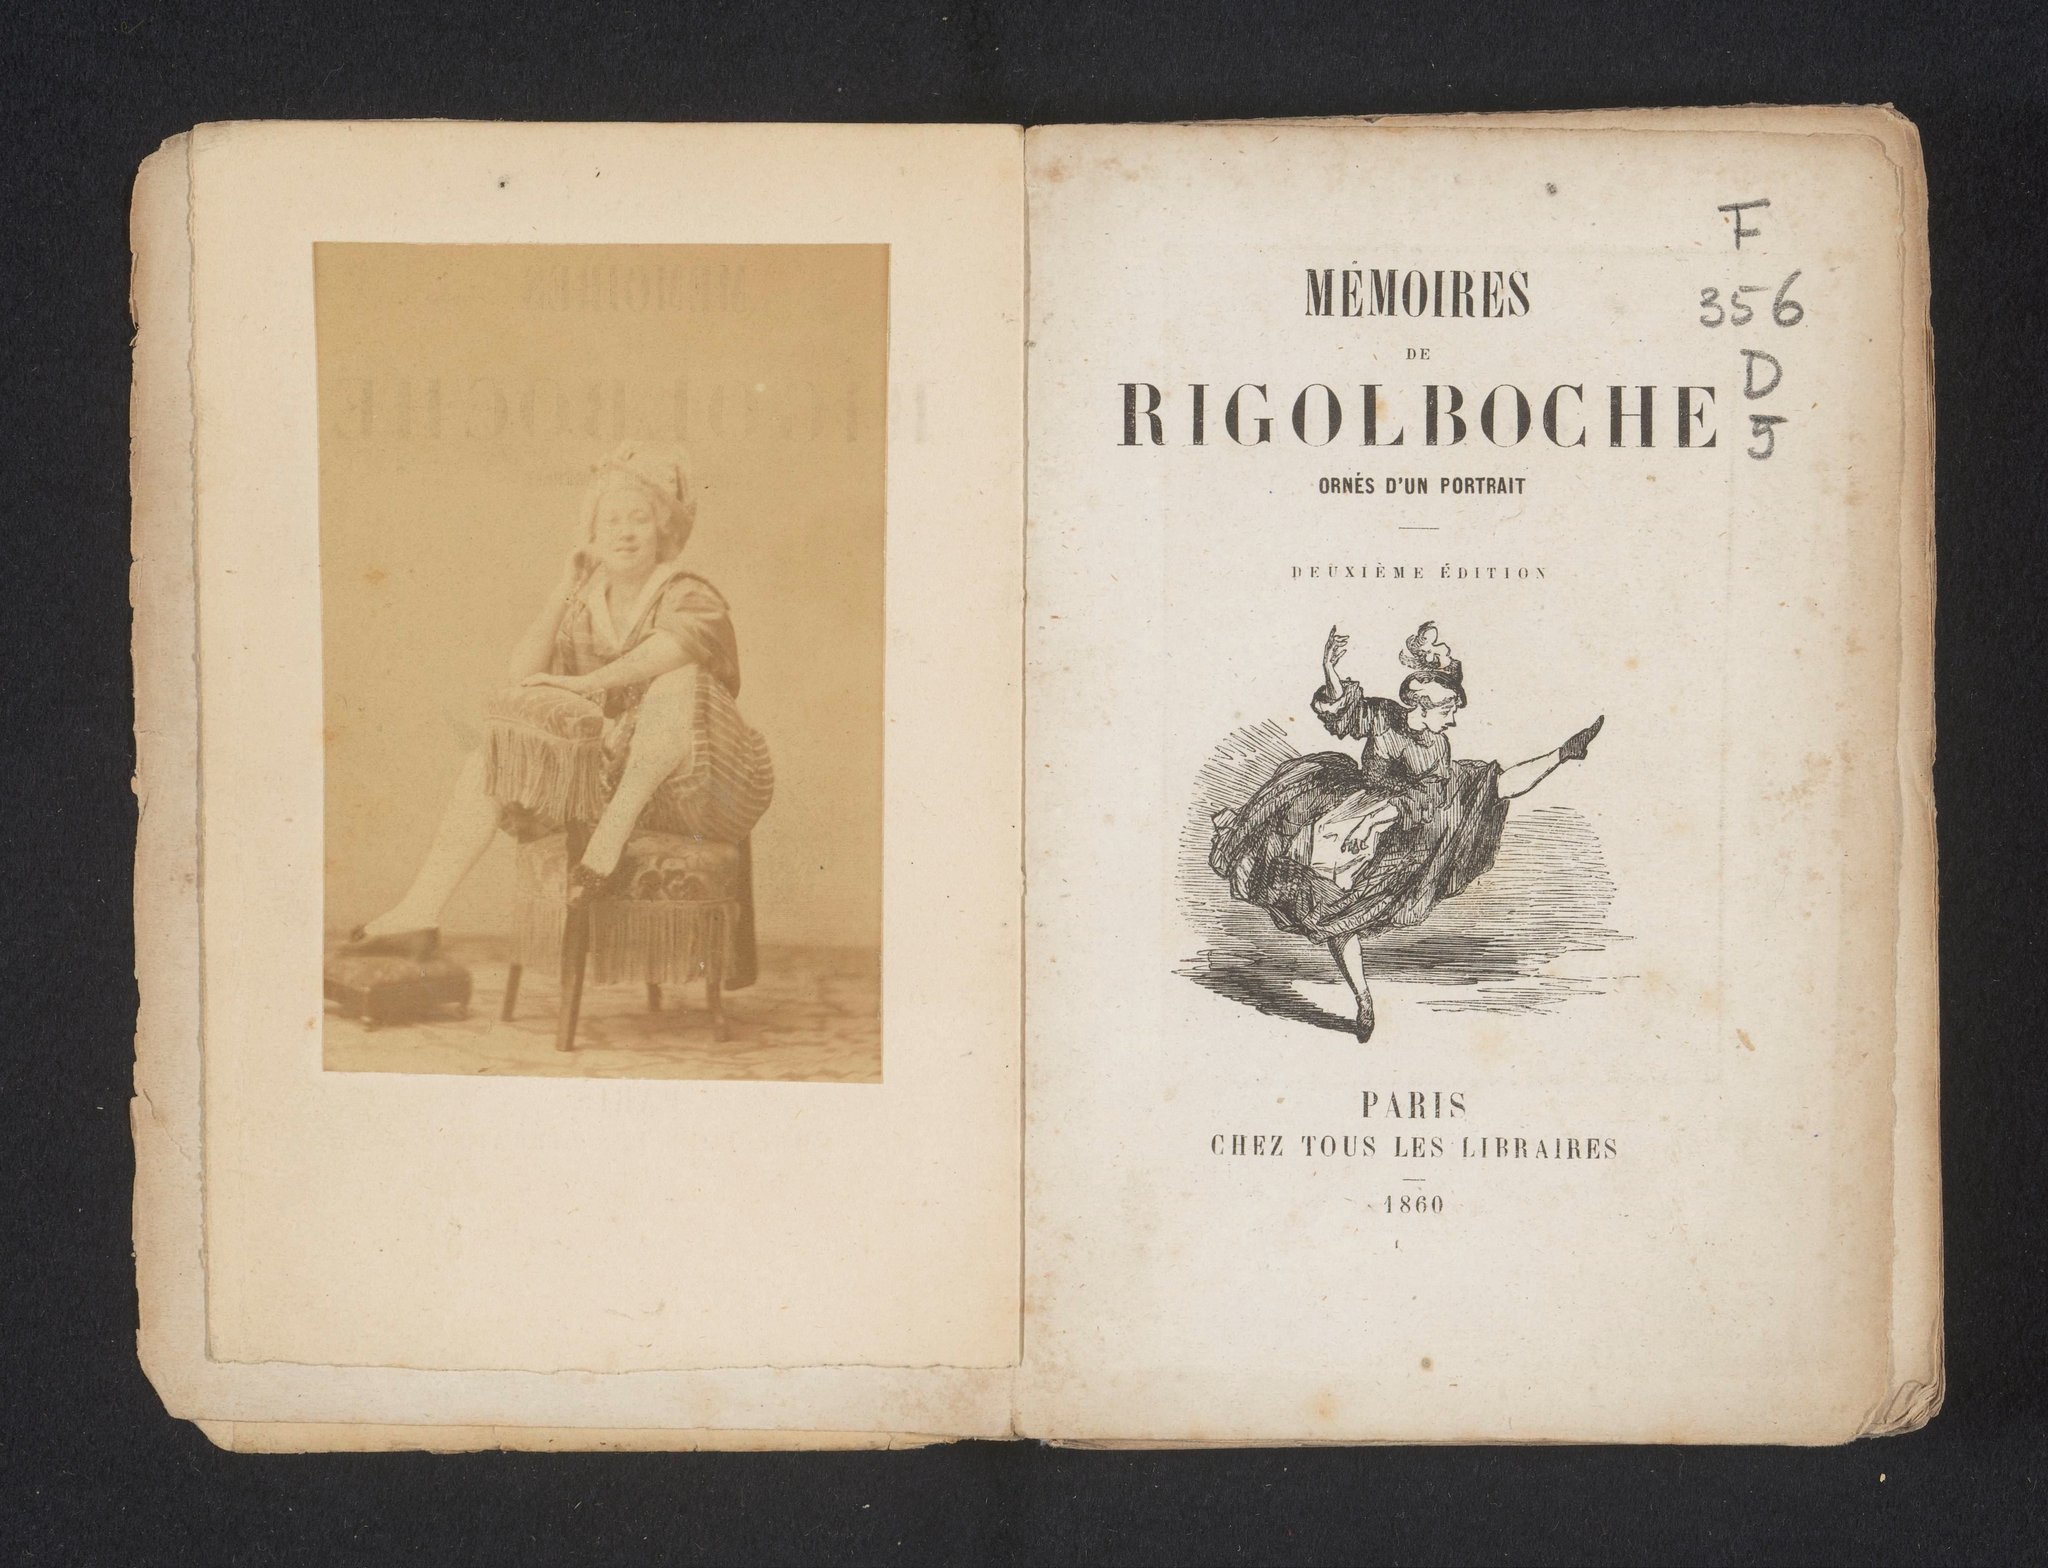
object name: page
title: Portret van Amelia Marguerite Badel, ook wel bekend als Rigolboche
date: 1850-1860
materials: photographic support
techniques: albumen print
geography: paris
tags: amelia marguerite badel, portrait of dancer